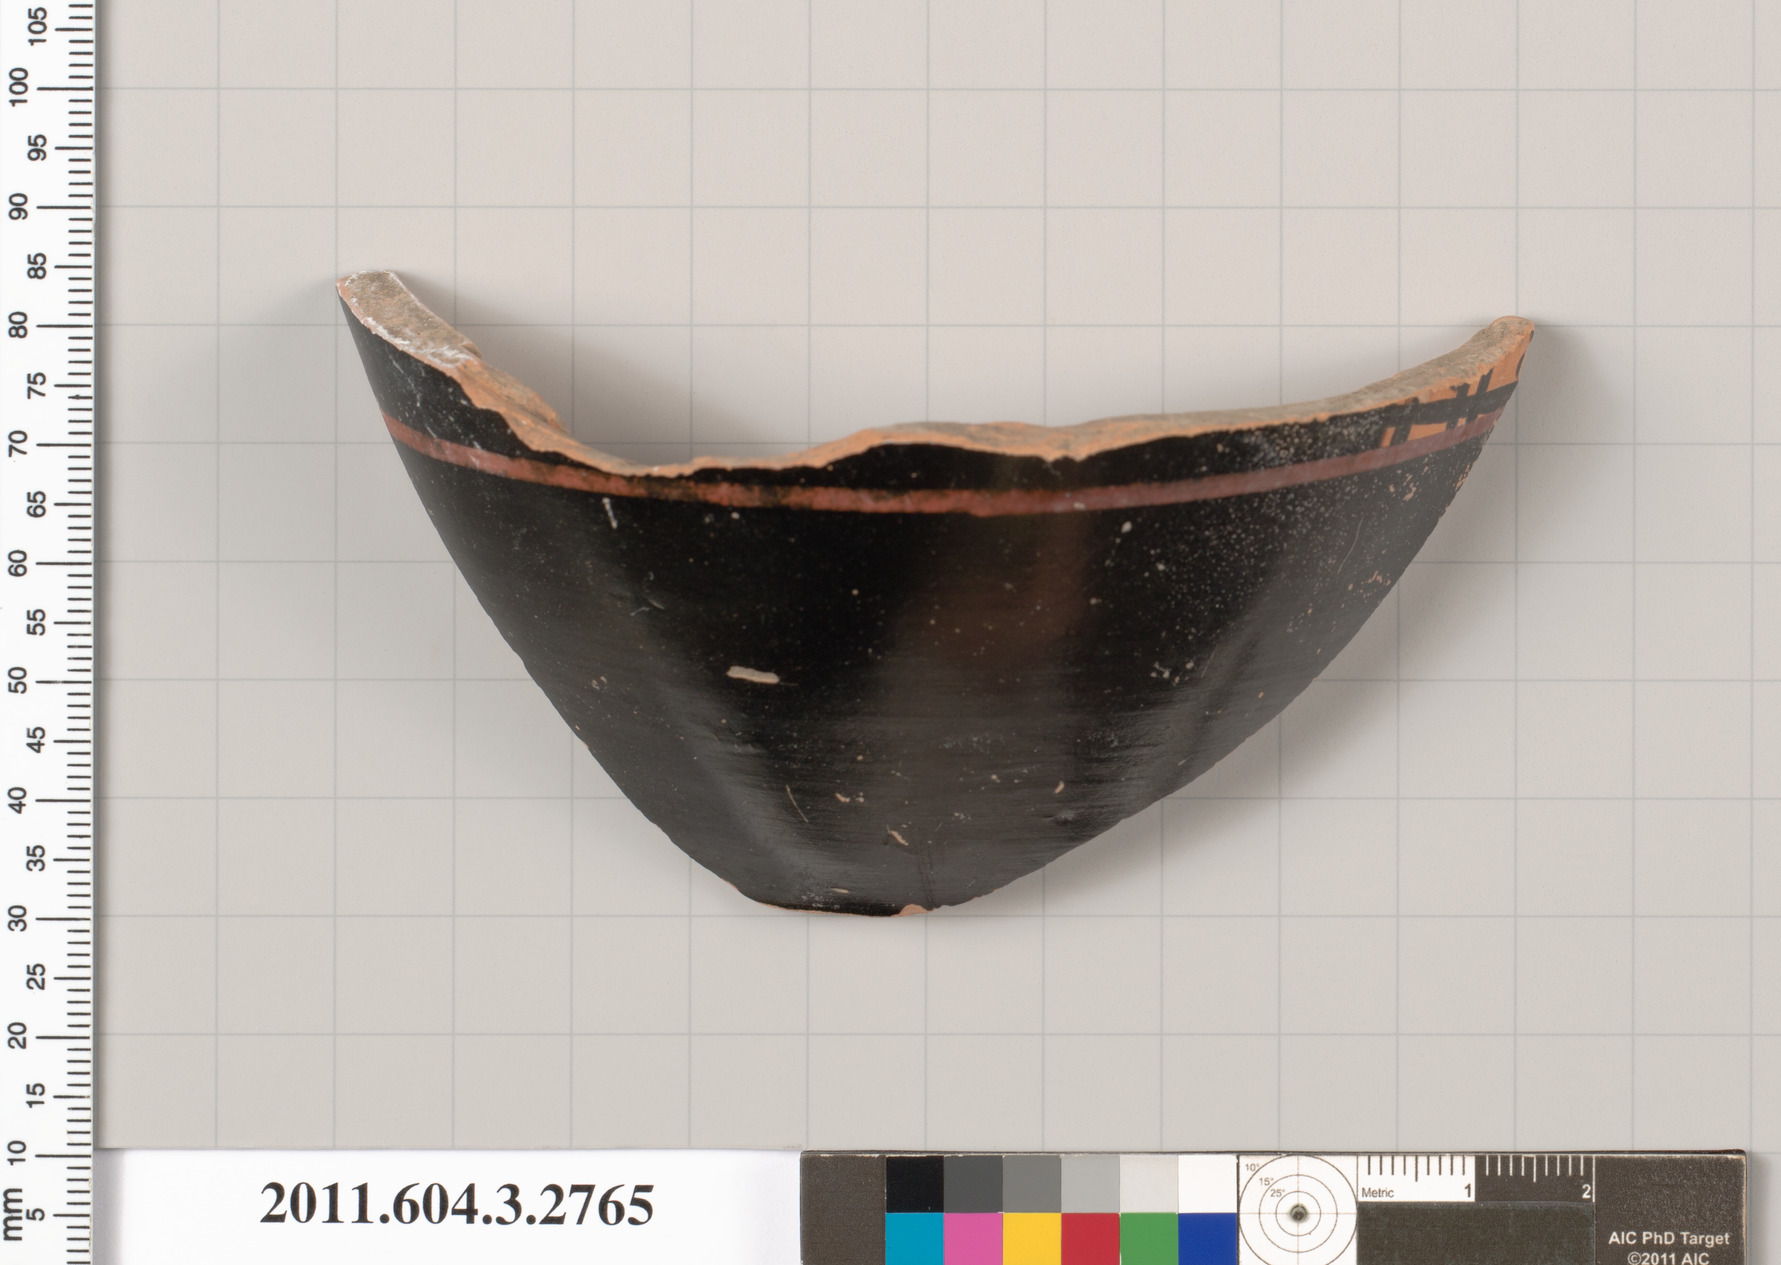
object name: oinochoe fragment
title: Terracotta fragment of an oinochoe (jug)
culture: greek, attic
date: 534-468 BCE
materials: terracotta